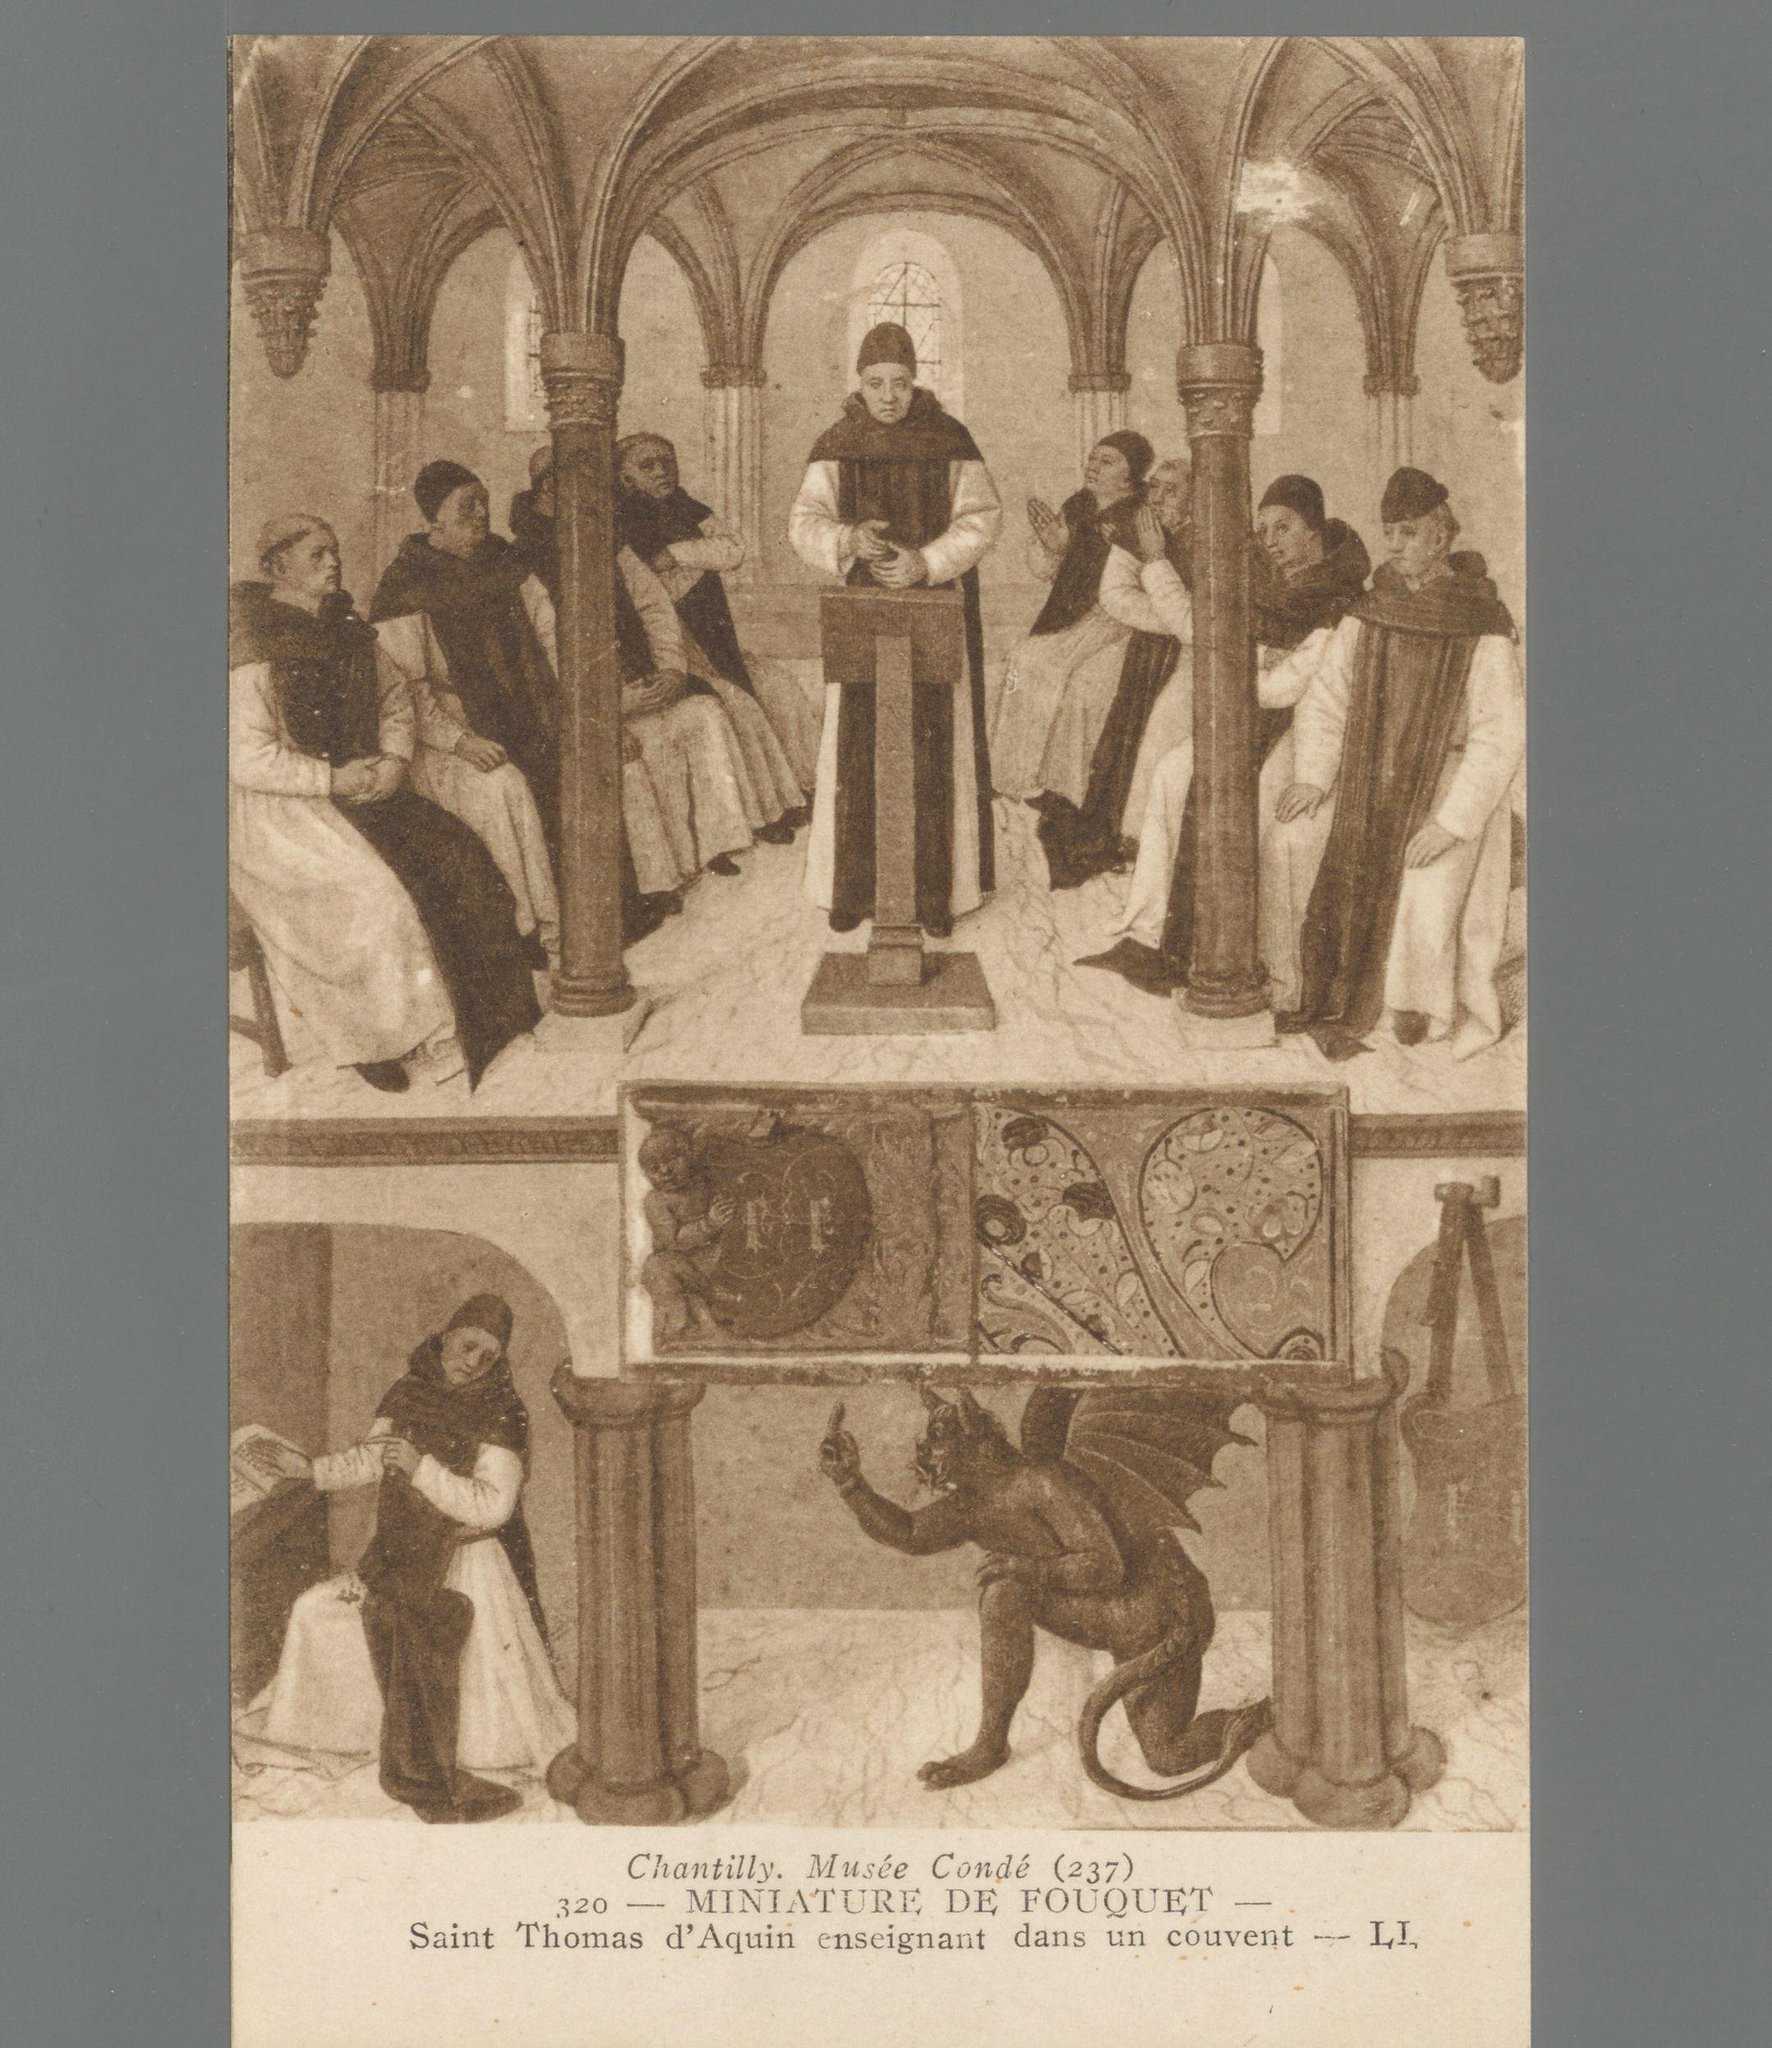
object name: reproduction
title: Chantilly. Musée Condé - Miniature de Fouquet - Saint Thomas d'Aquin enseignant dans un couvent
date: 1903-1932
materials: cardboard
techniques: photograph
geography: paris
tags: abbey, monastery, convent ~ roman catholic church, permanent exhibition, museum, picture, painting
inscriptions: collector's mark: ‘AFE v S’